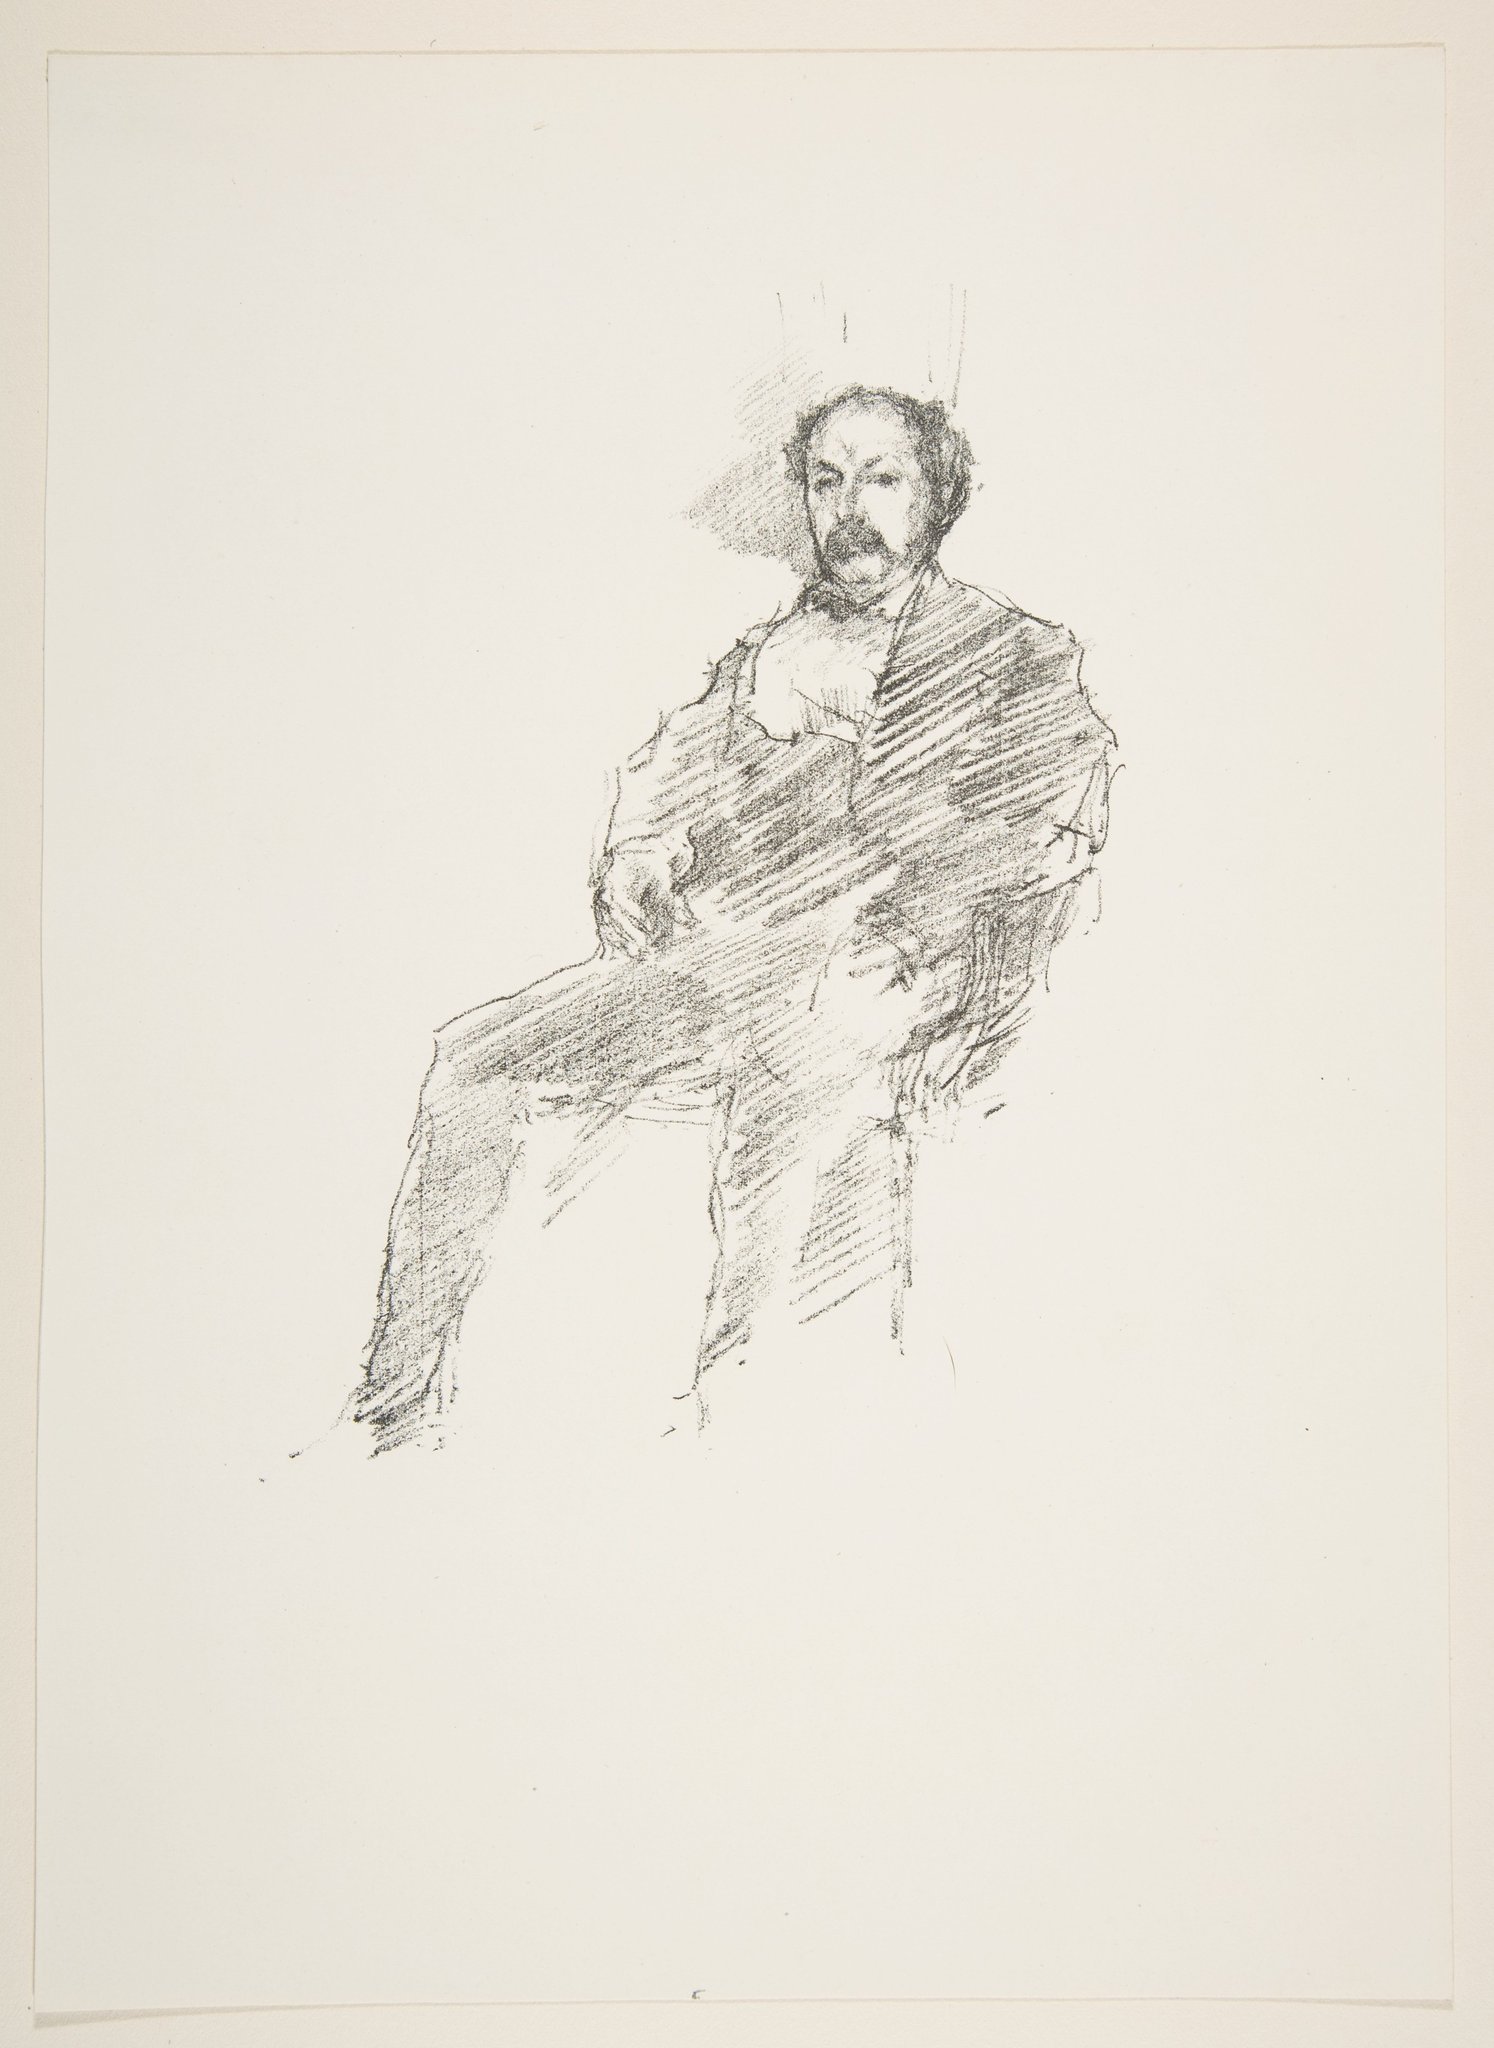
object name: print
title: The Doctor, from "The Pageant"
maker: james mcneill whistler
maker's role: artist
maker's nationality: american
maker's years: 1834-1903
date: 1894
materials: ink, paper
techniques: printing, lithography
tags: men